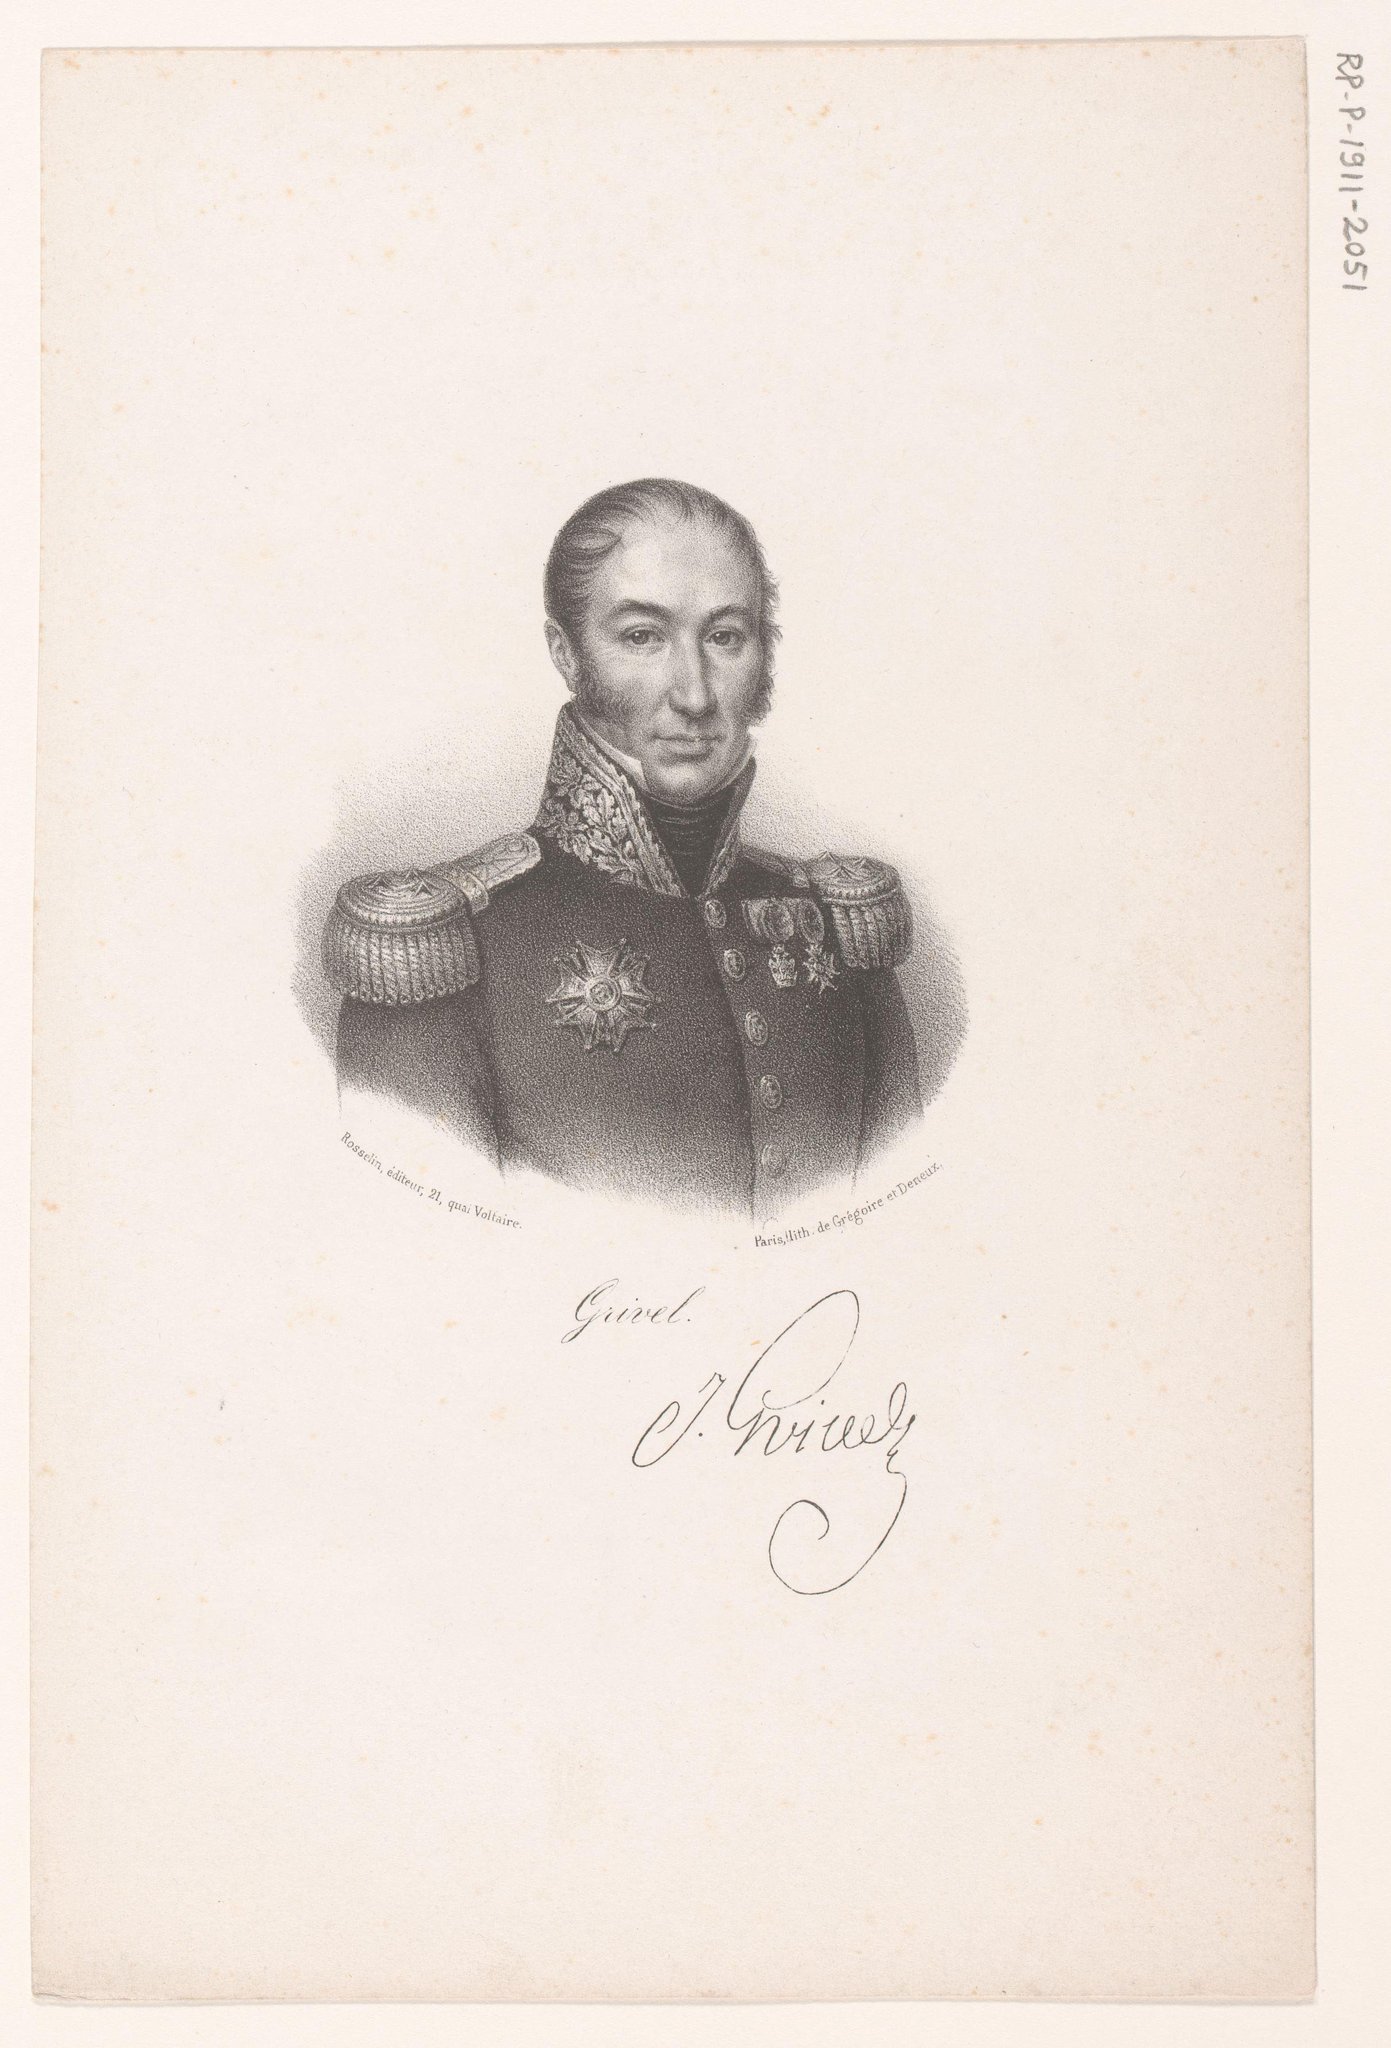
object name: print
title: Portret van Jean-Baptiste Grivel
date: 1844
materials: paper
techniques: lithograph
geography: paris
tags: historical persons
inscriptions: collector's mark: Lugt 2228a